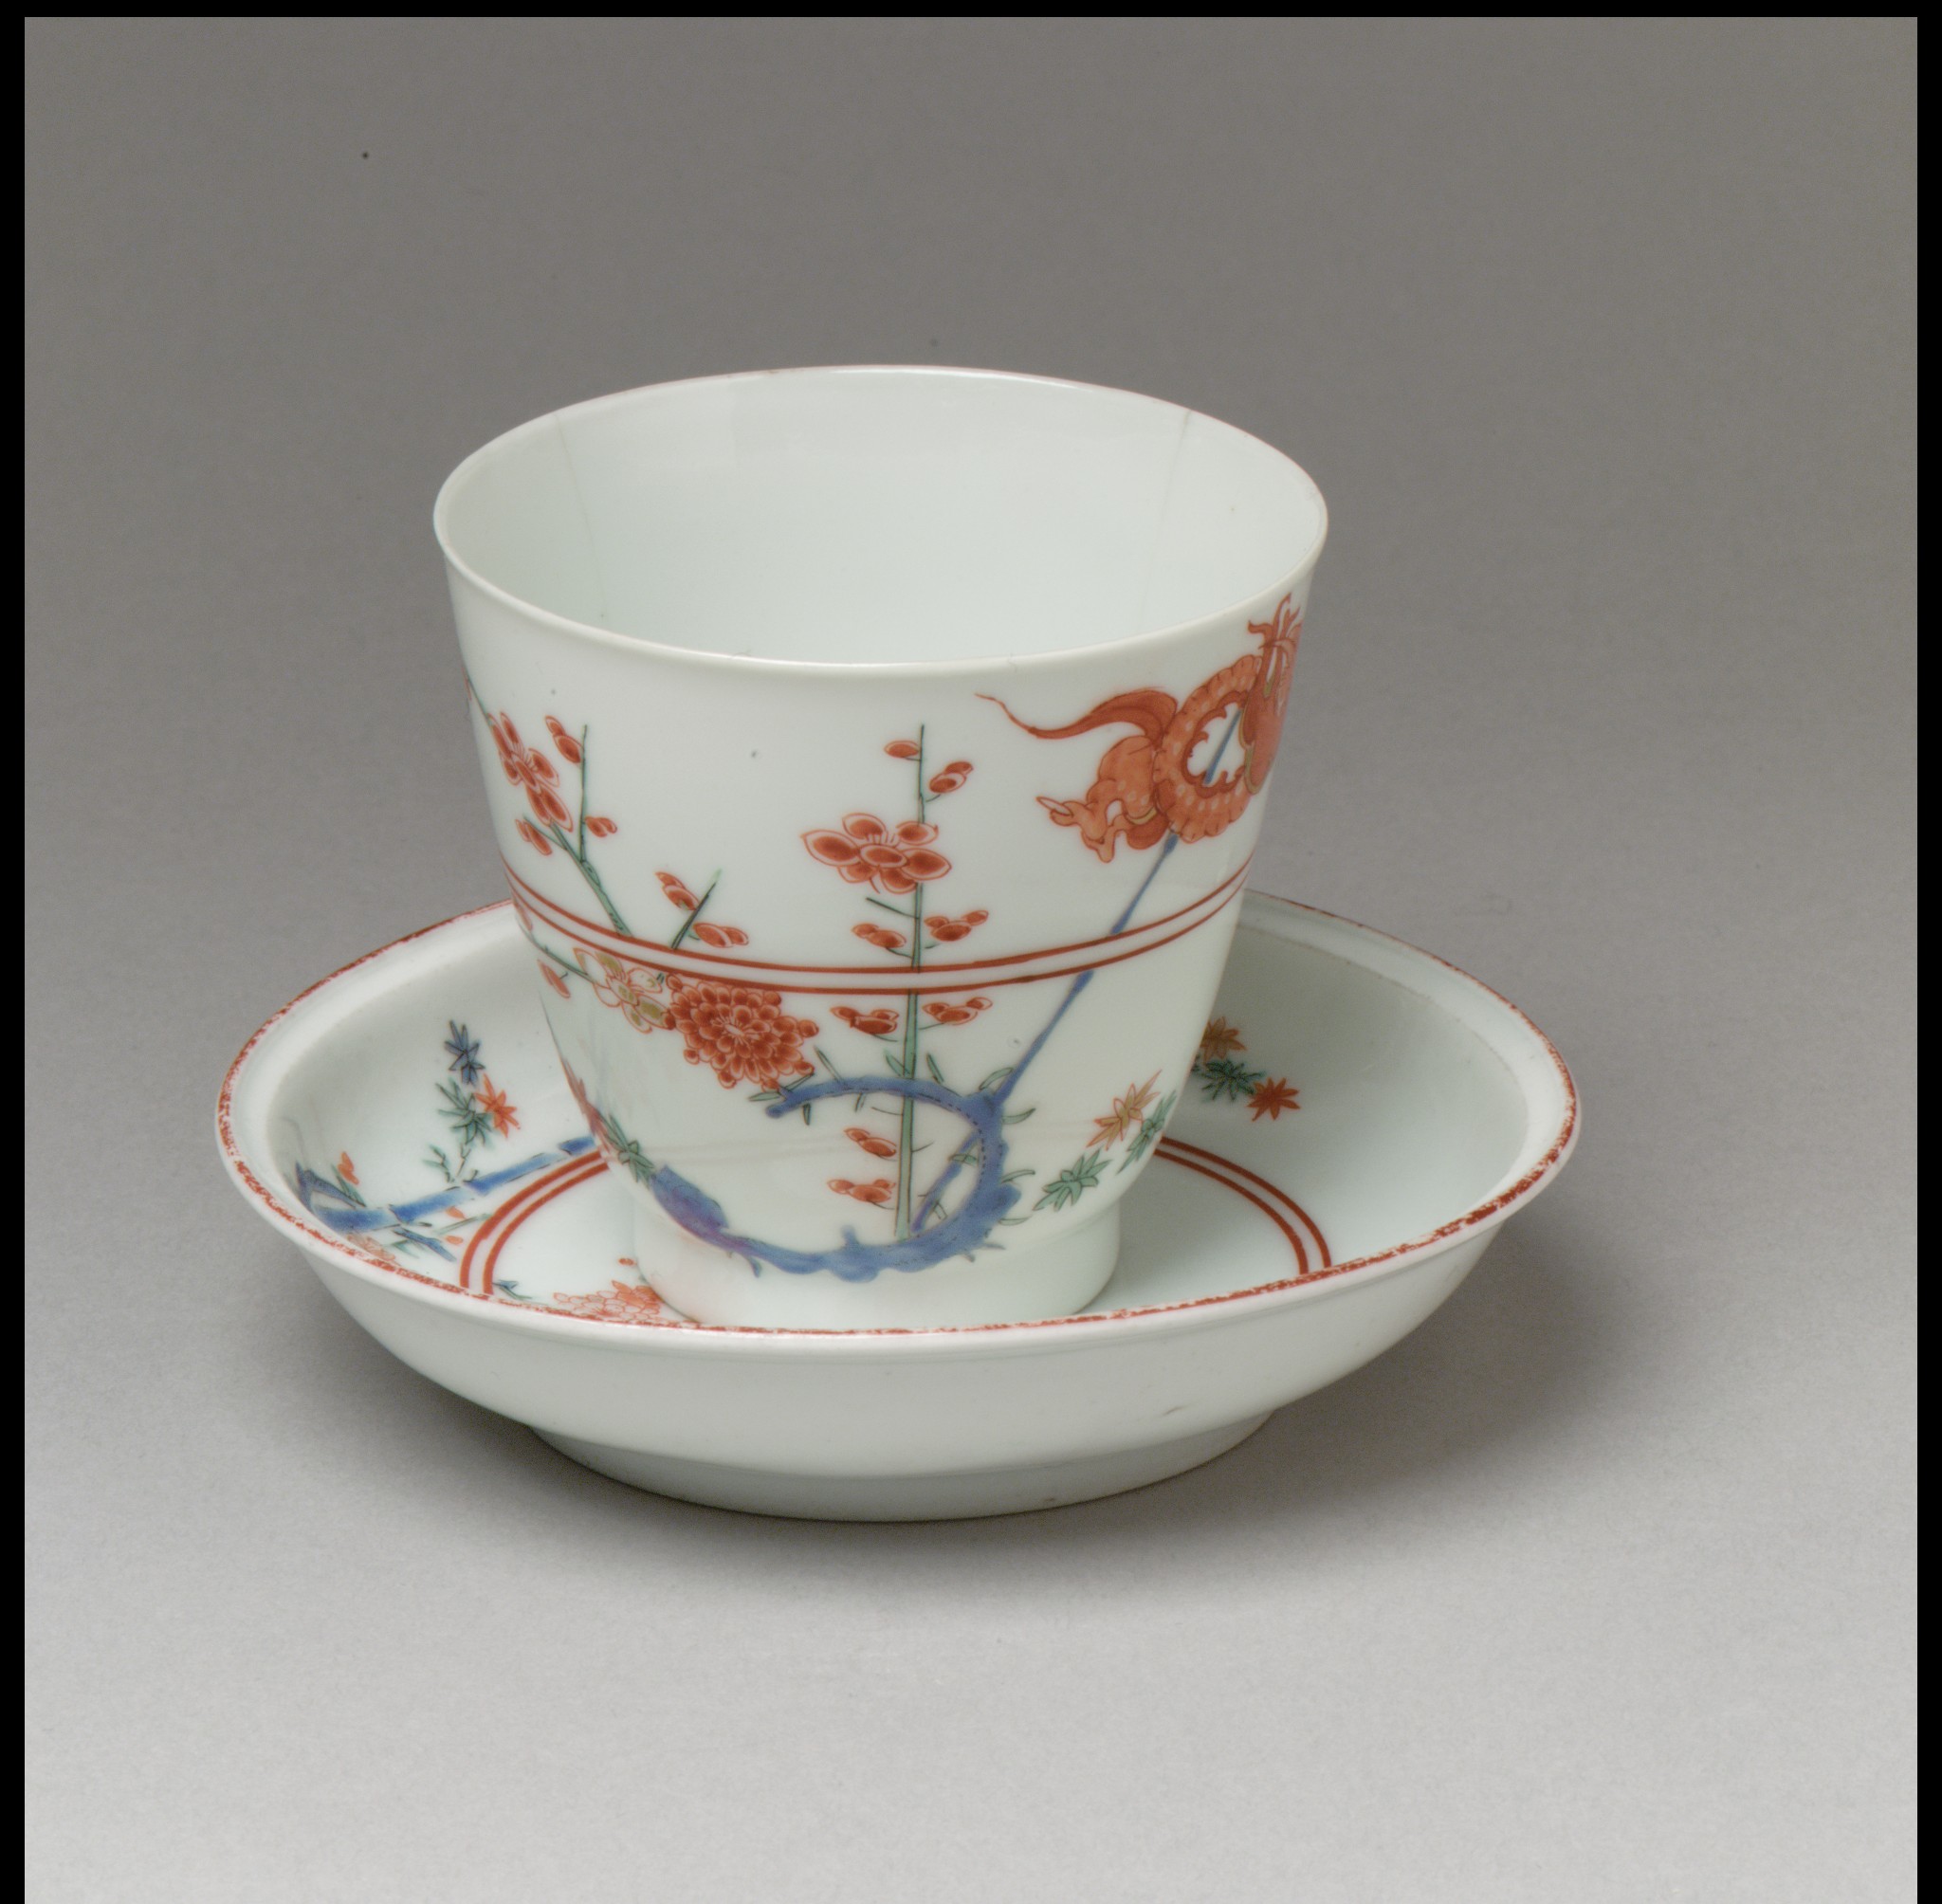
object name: beaker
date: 1700-1720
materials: hard paste porcelain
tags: dragons,flowers